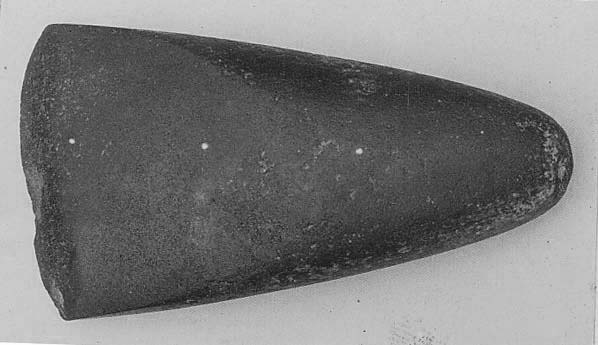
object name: hatchet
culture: swiss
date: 1902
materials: jade